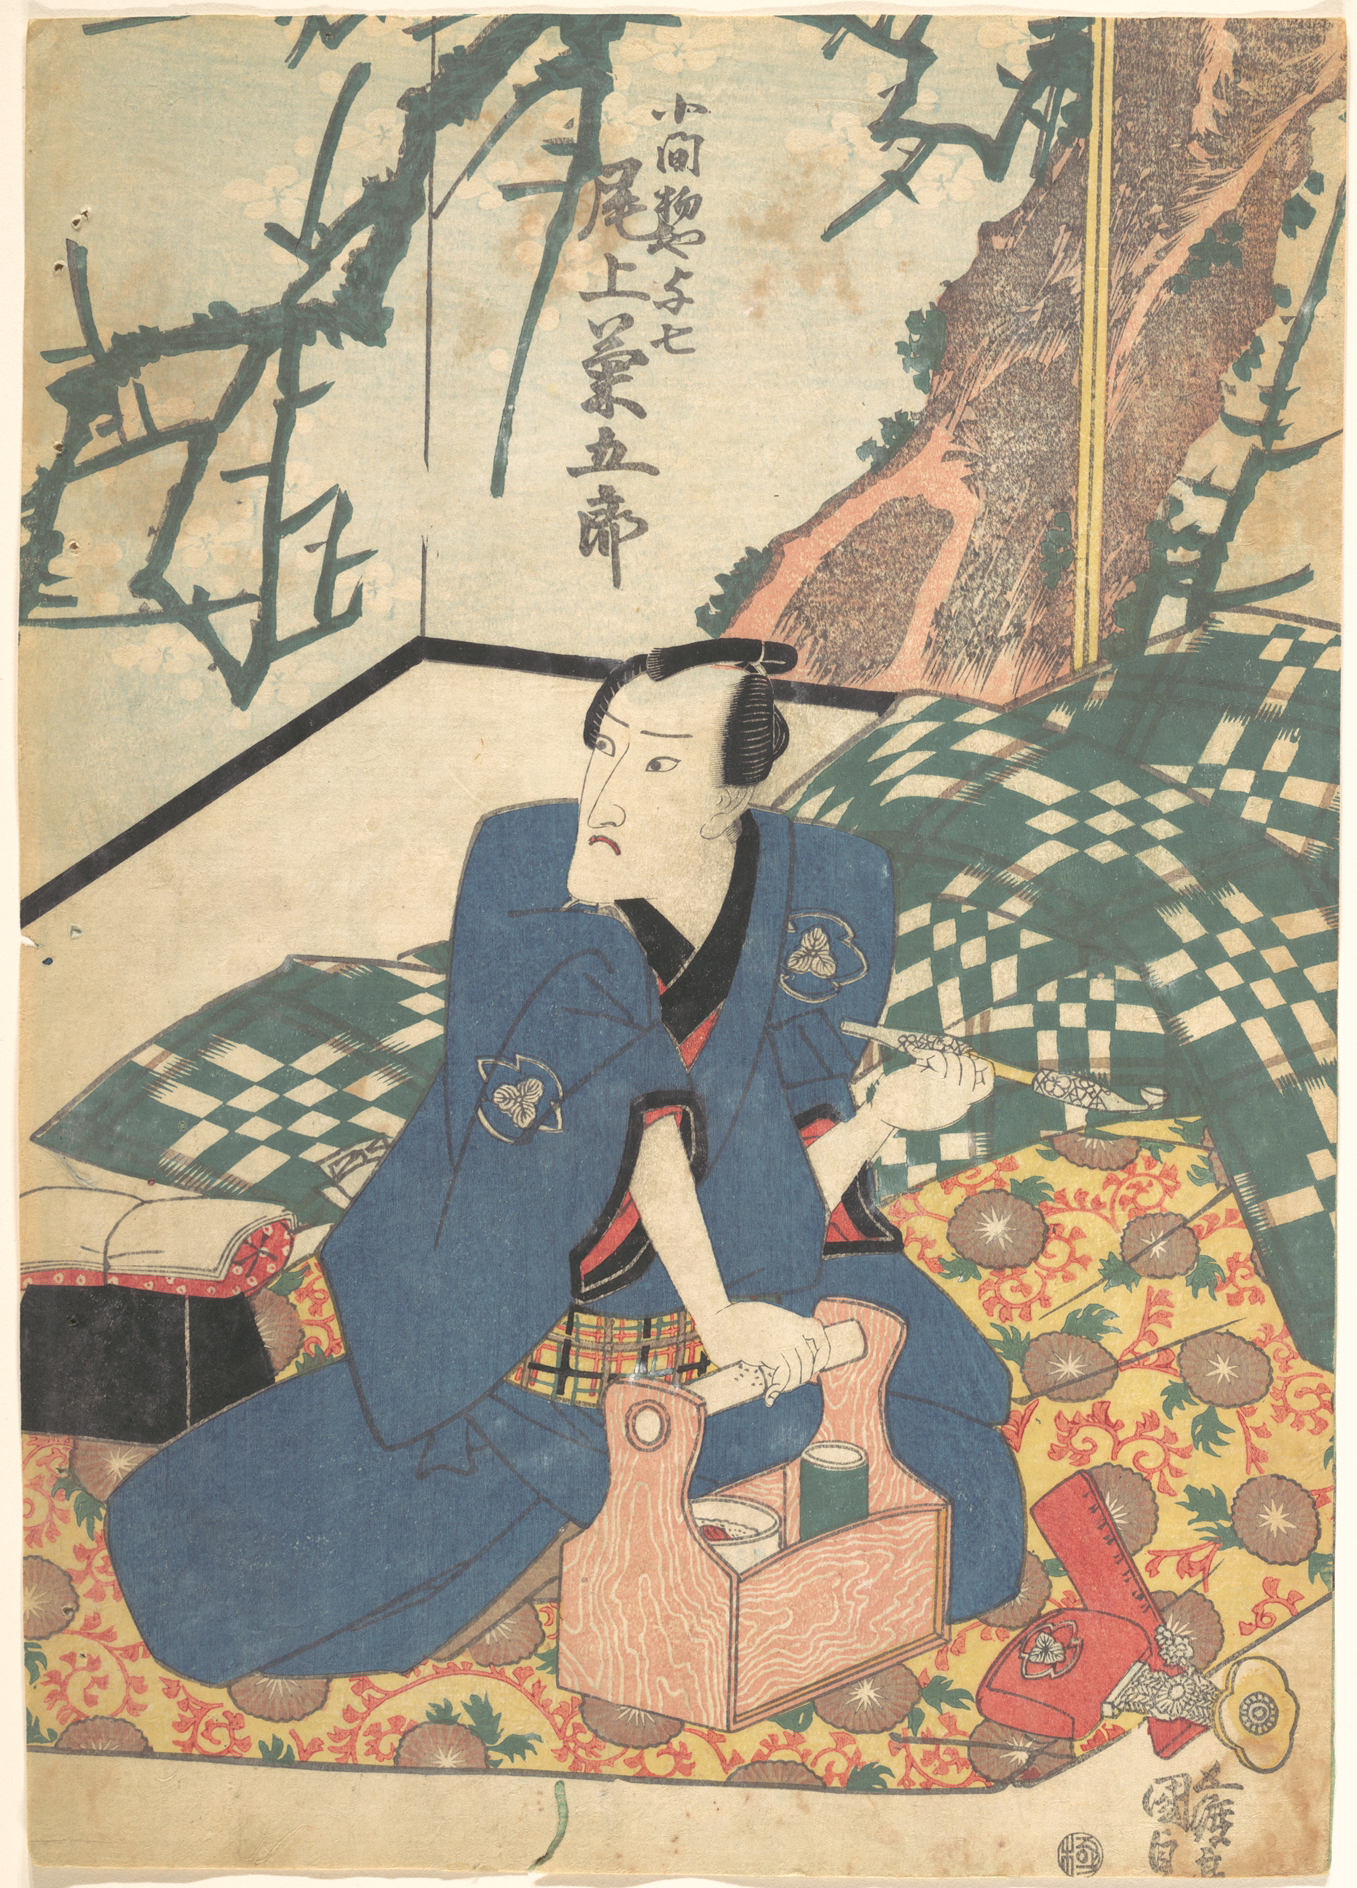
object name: print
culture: japanese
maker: utagawa kunisada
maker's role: artist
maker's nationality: japanese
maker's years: 1786-1864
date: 1801-1900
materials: ink, paper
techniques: woodblock print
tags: men